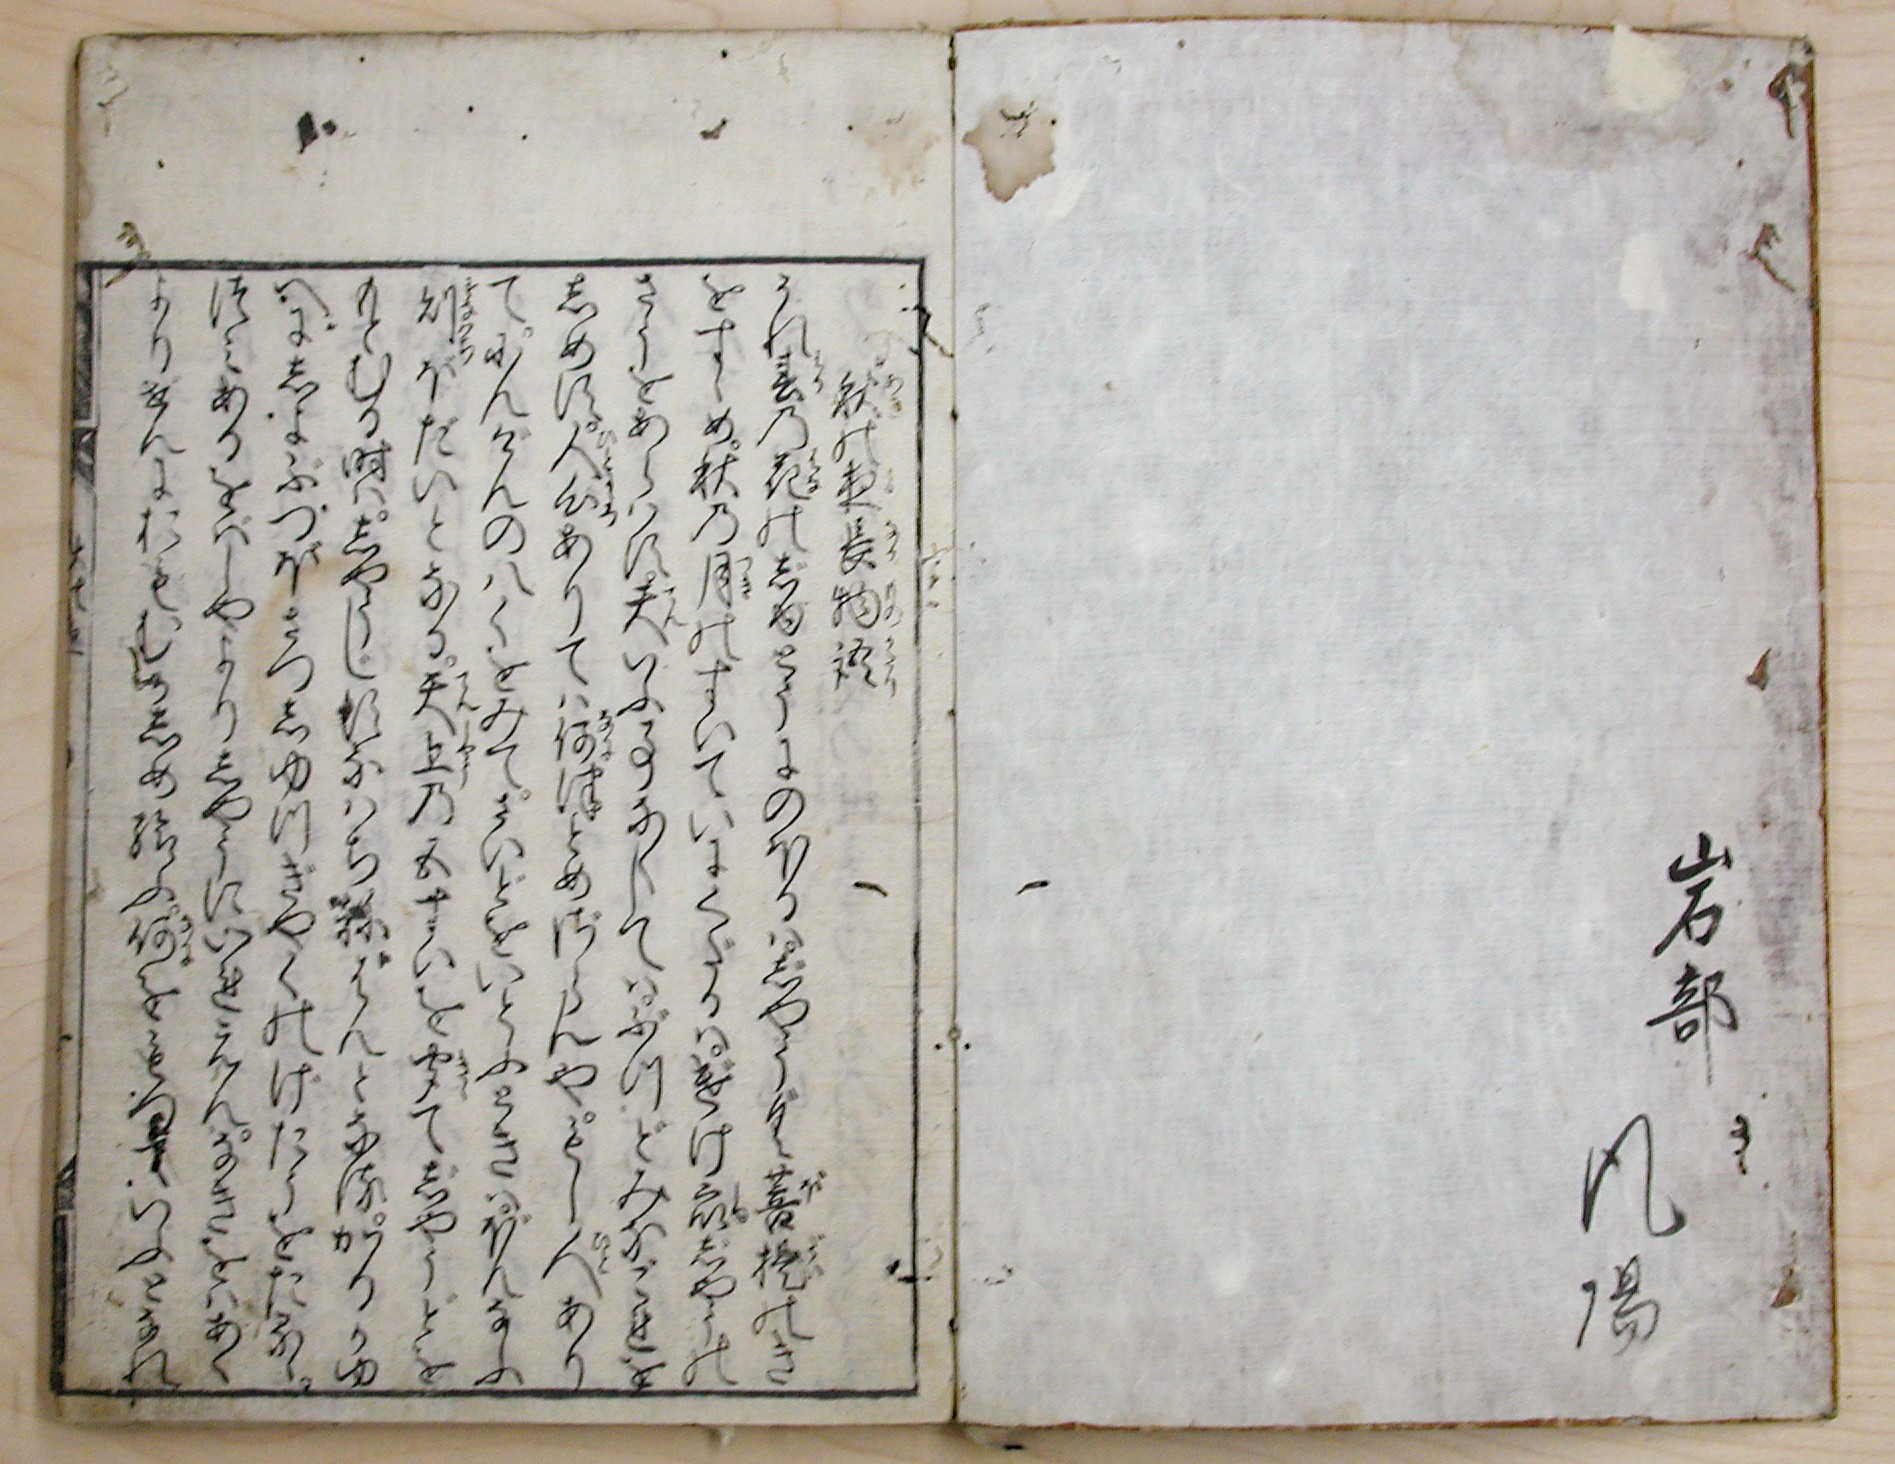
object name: book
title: Printed Book of the Text for A Long Tale for an Autumn Night (Aki no yo no nagamonogatari)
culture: japanese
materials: ink, paper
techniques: printing